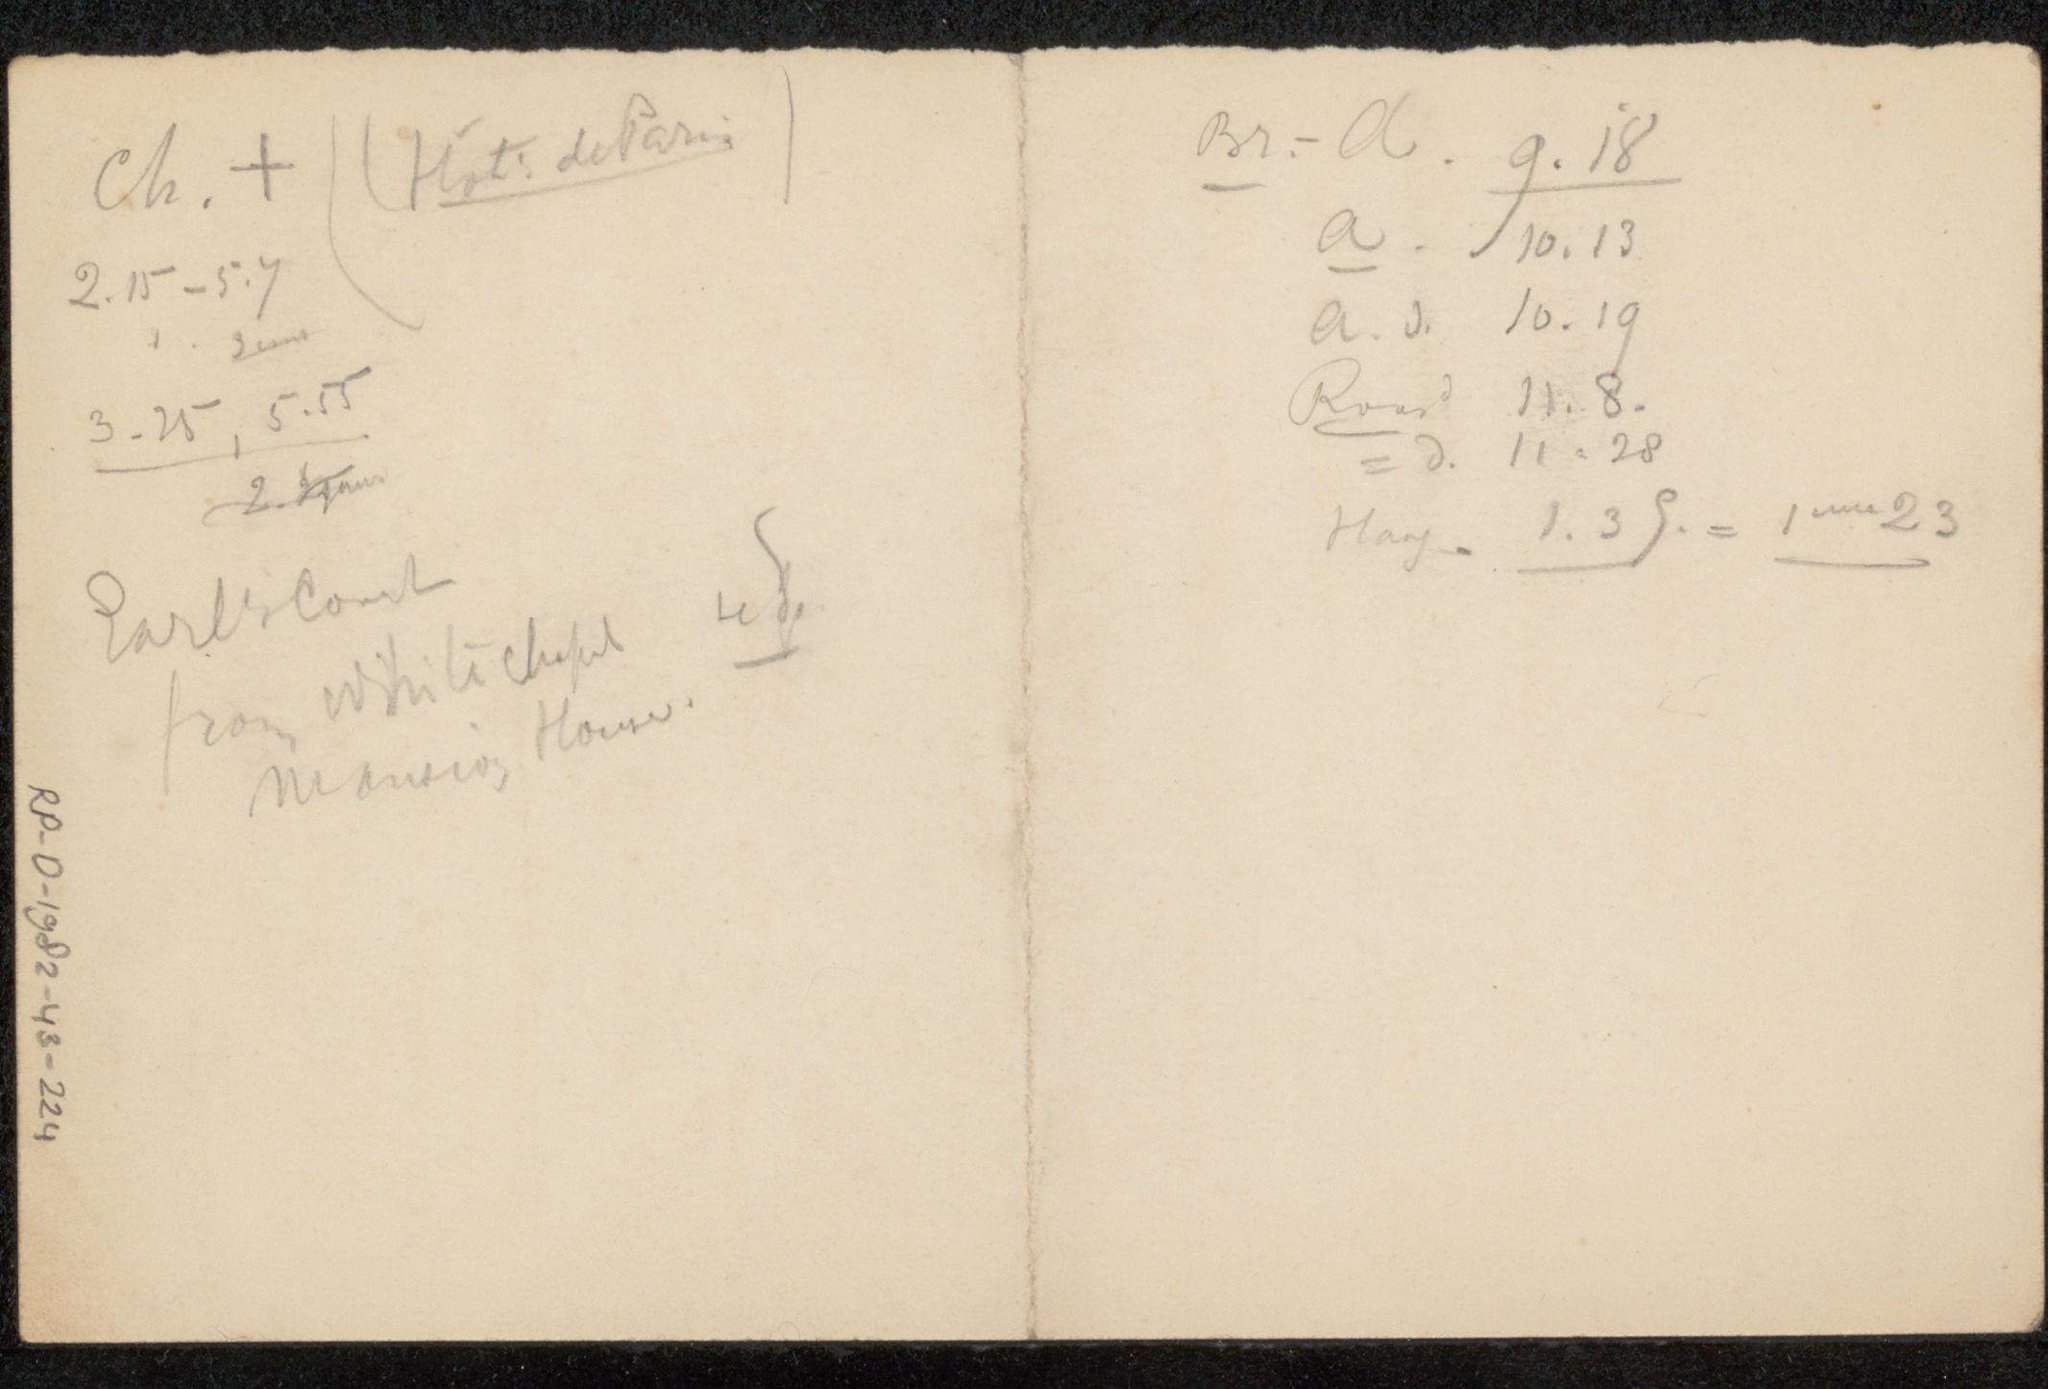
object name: aantekening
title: Aantekening uit archief Philip Zilcken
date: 1867-1922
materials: paper, pencil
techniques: writing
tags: london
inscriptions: watermark